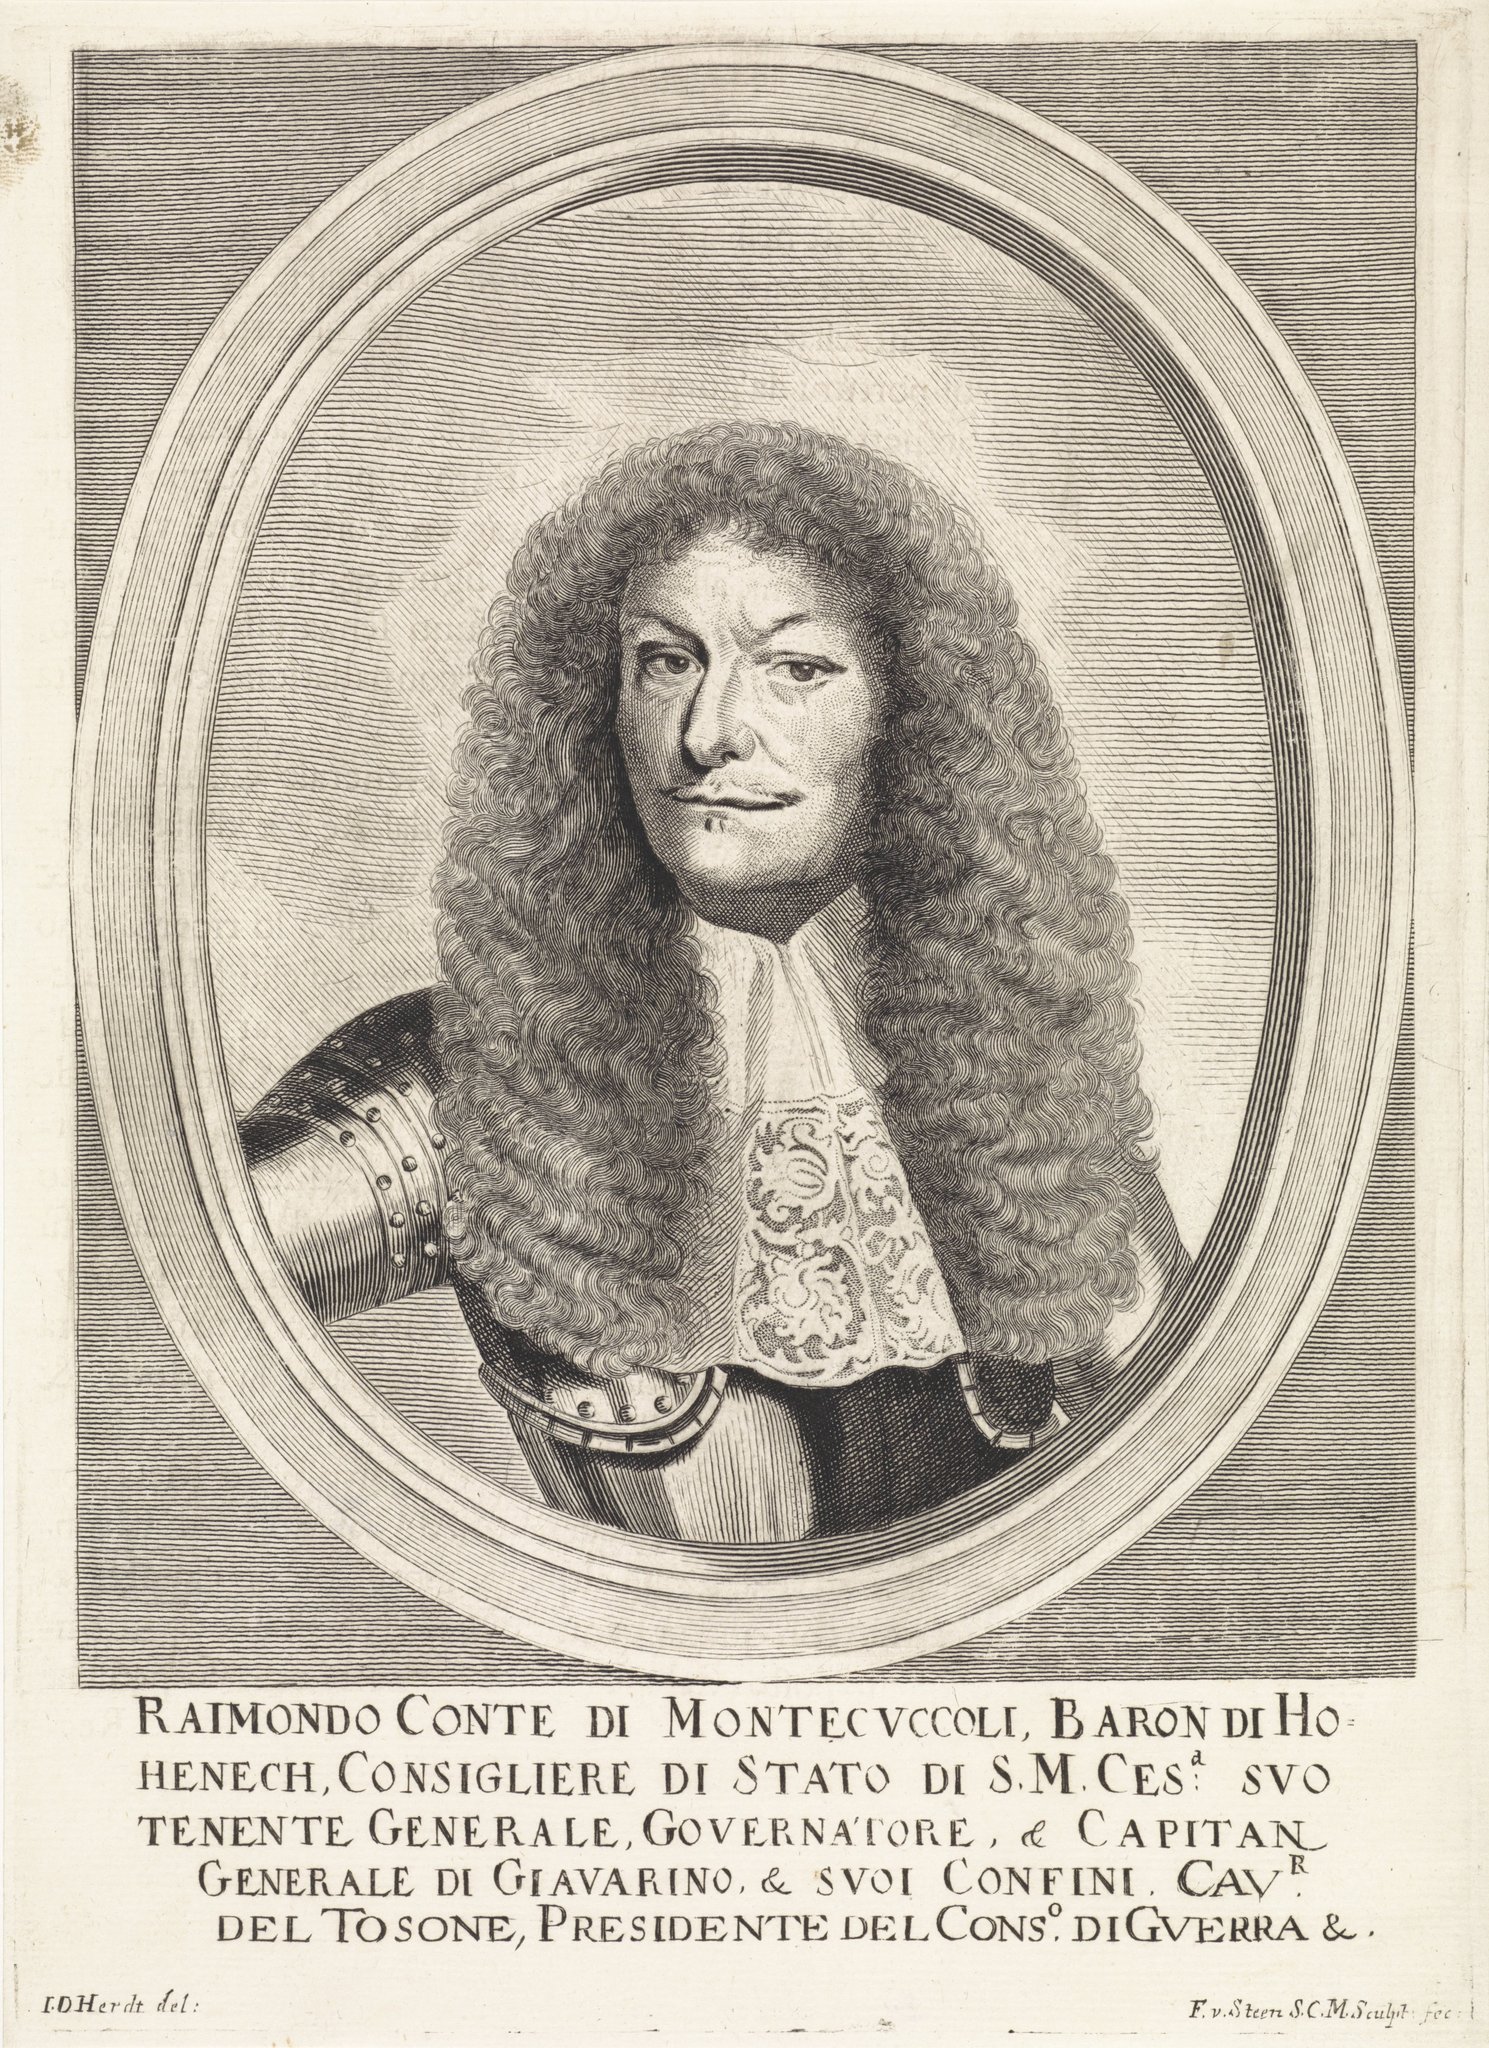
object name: book illustration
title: Portret van graaf Raimondo Montecuccoli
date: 1670-1674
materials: paper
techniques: engraving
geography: vienna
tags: emilia-romagna, linz, staatsman, veldheer, veldmaarschalk, raimondo montecuccoli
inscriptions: collector's mark: Lugt 2228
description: Prent mogelijk gebruikt in: Gualdo Priorato, Galeazzo. Historia di Leopoldo Cesare, (...). 3 dln. Wenen, Giovanni Battista Hacque, 1670-1674.